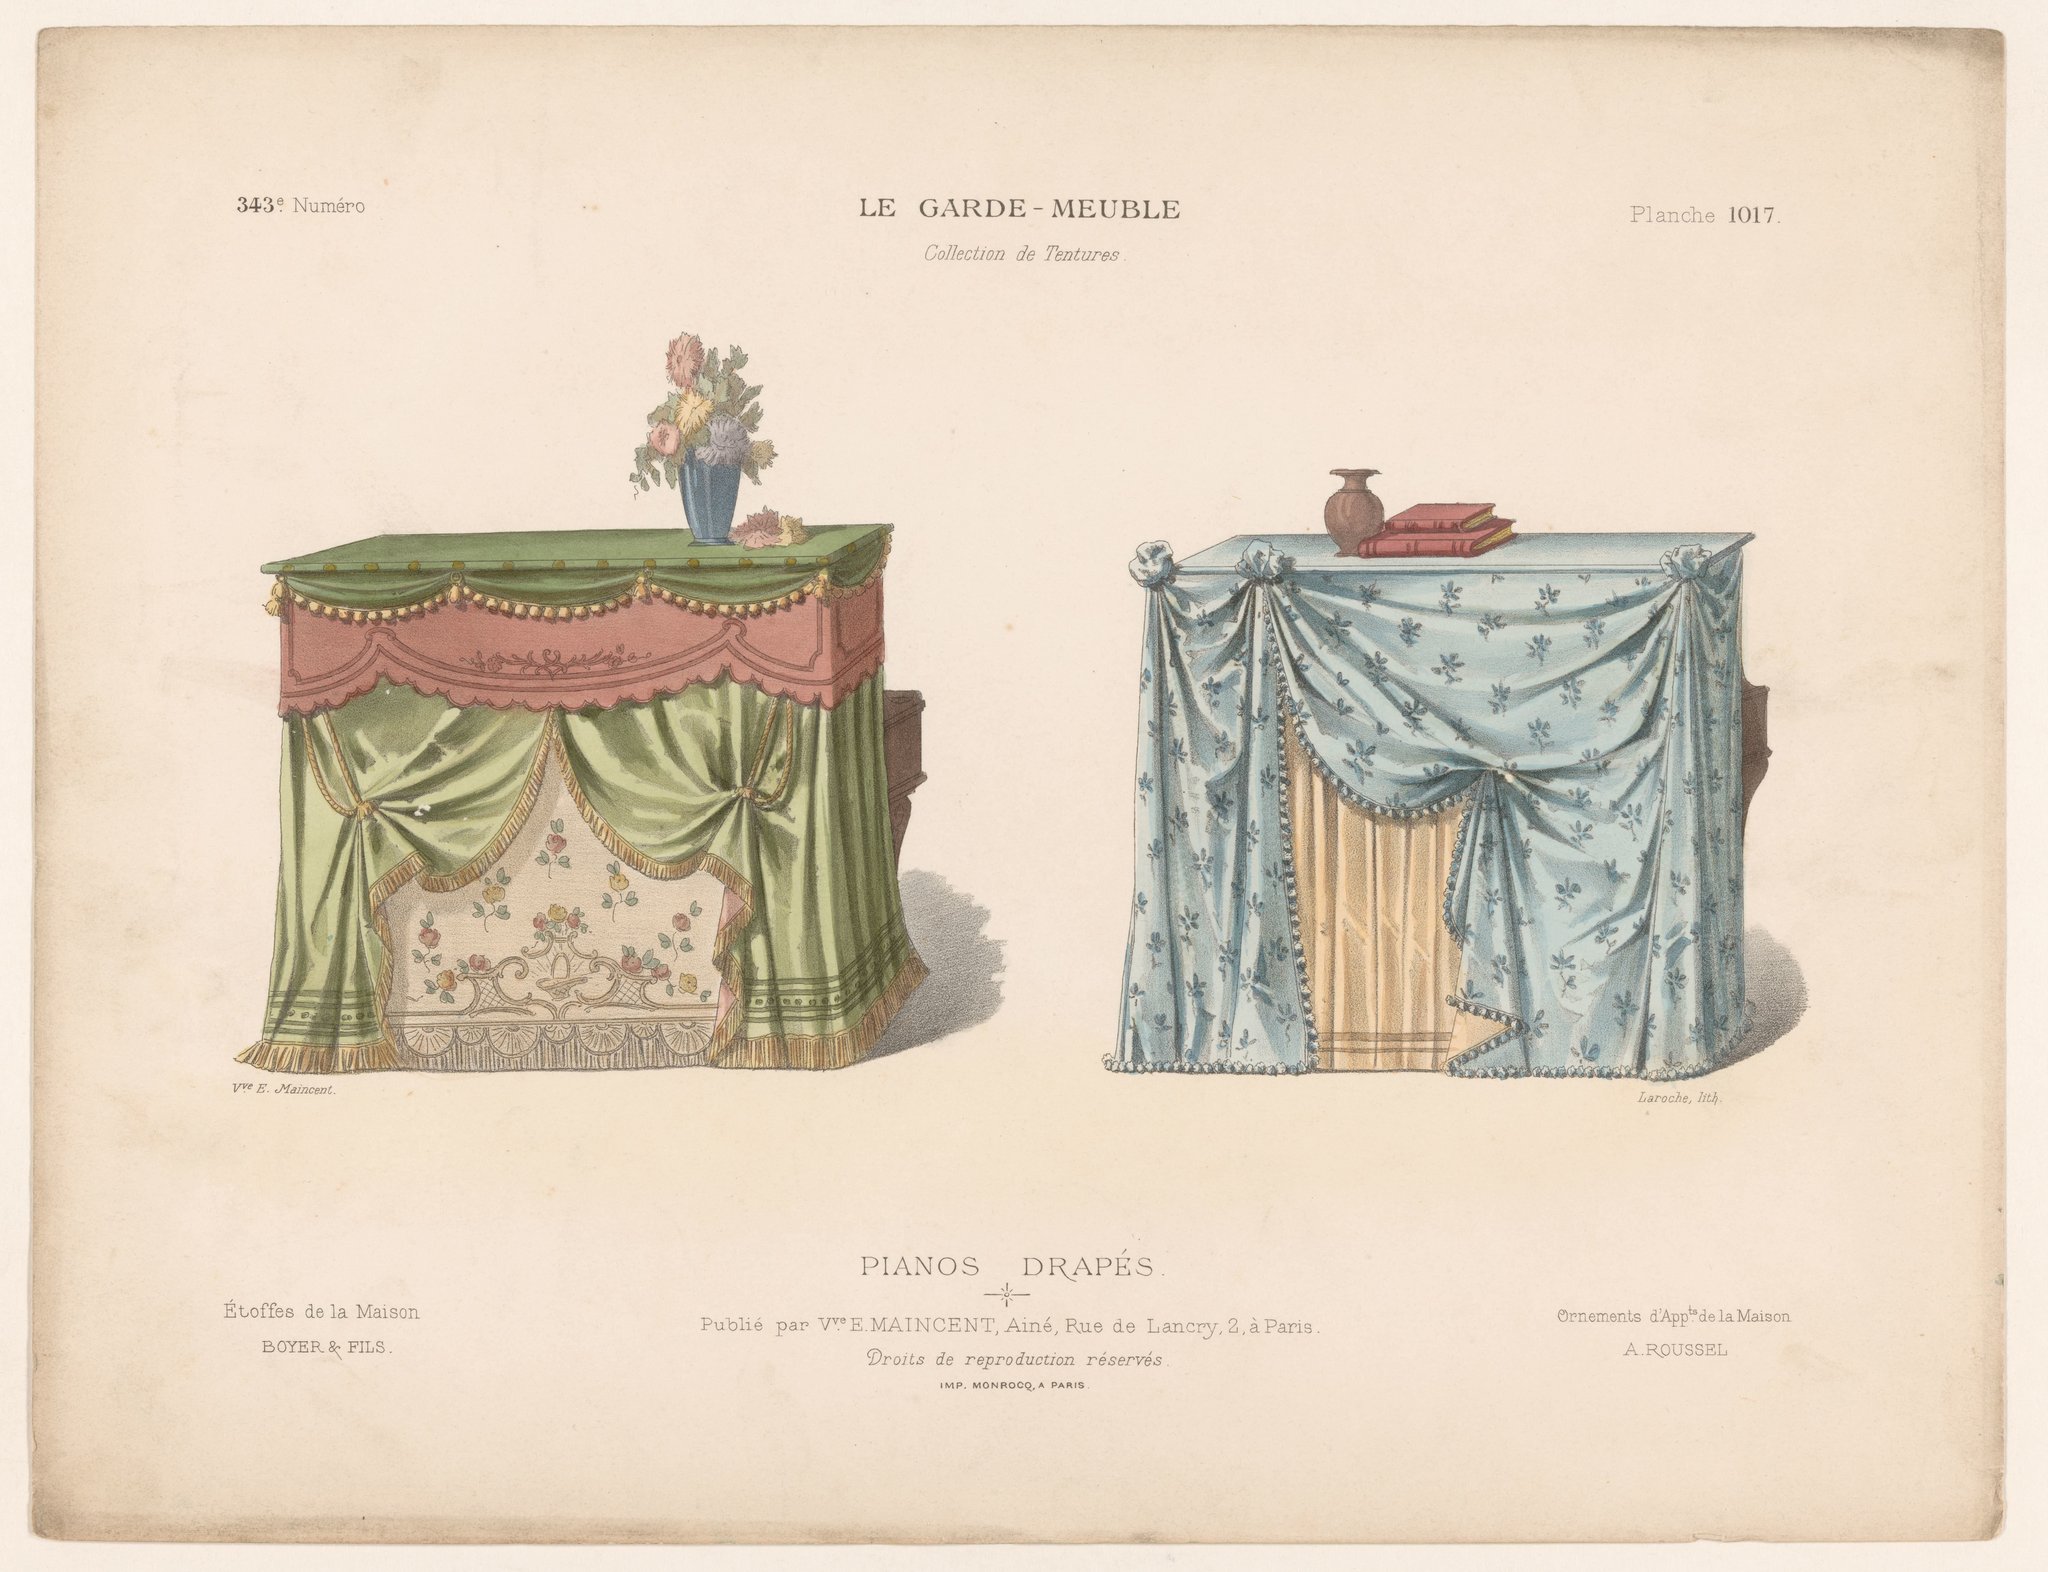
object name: print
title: Piano's met draperieën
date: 1895-1910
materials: paper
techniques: hand coloring, lithograph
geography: paris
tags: hangings and drapery, pianoforte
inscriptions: : ‘Droits de reproduction réservés.’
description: Twee piano's met draperieën. Prent uit 343e Livraison.